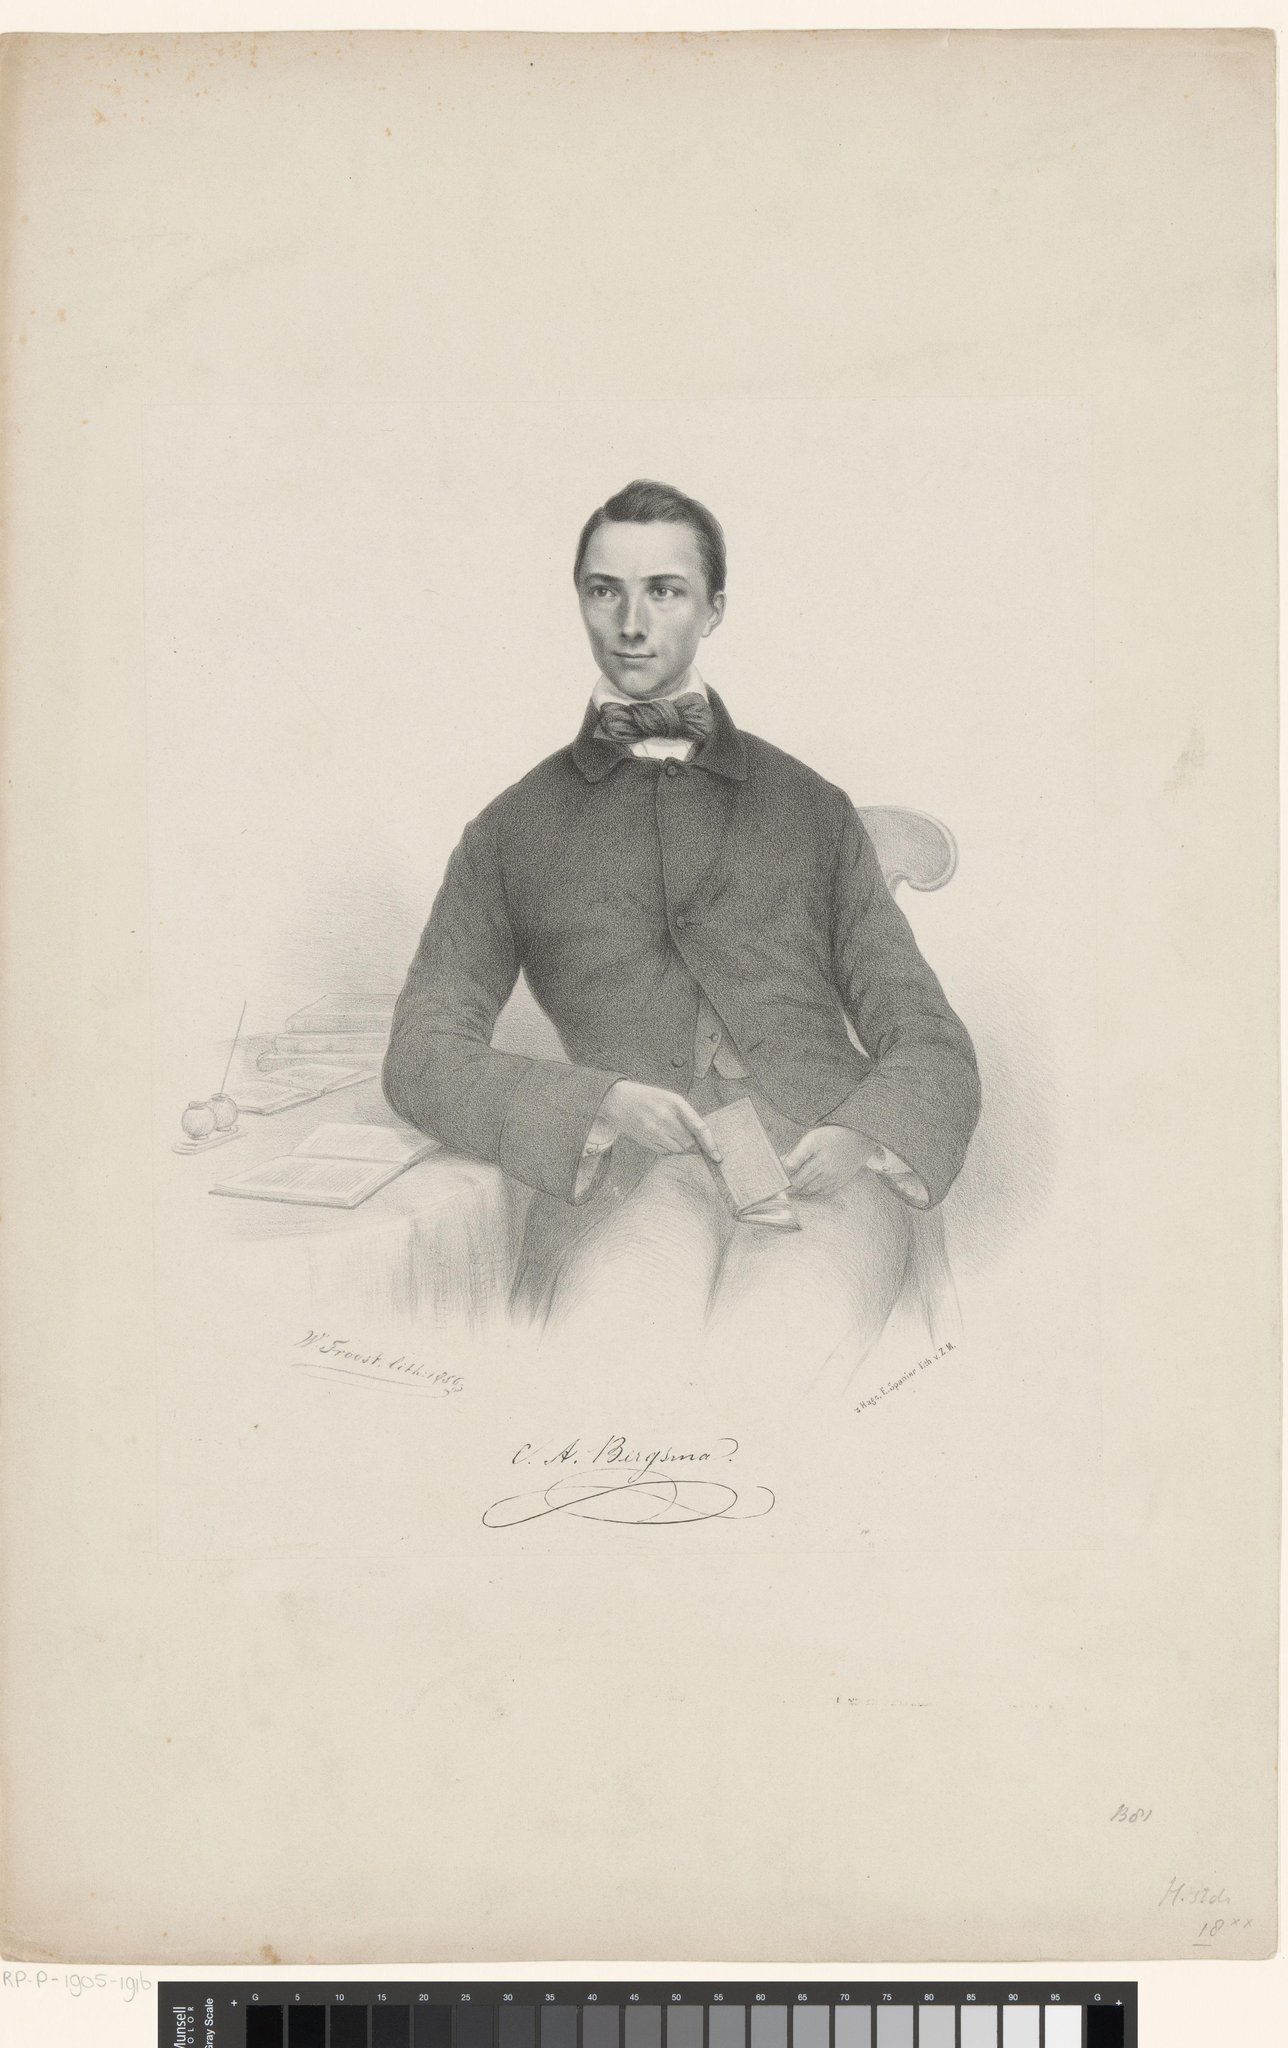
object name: print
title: Portret van Cornelis Adriaan Bergsma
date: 1856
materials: paper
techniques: lithograph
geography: the hague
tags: utrecht, historical persons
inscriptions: collector's mark: Lugt 2228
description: Onder het portret de signatuur van de geportretteerde.